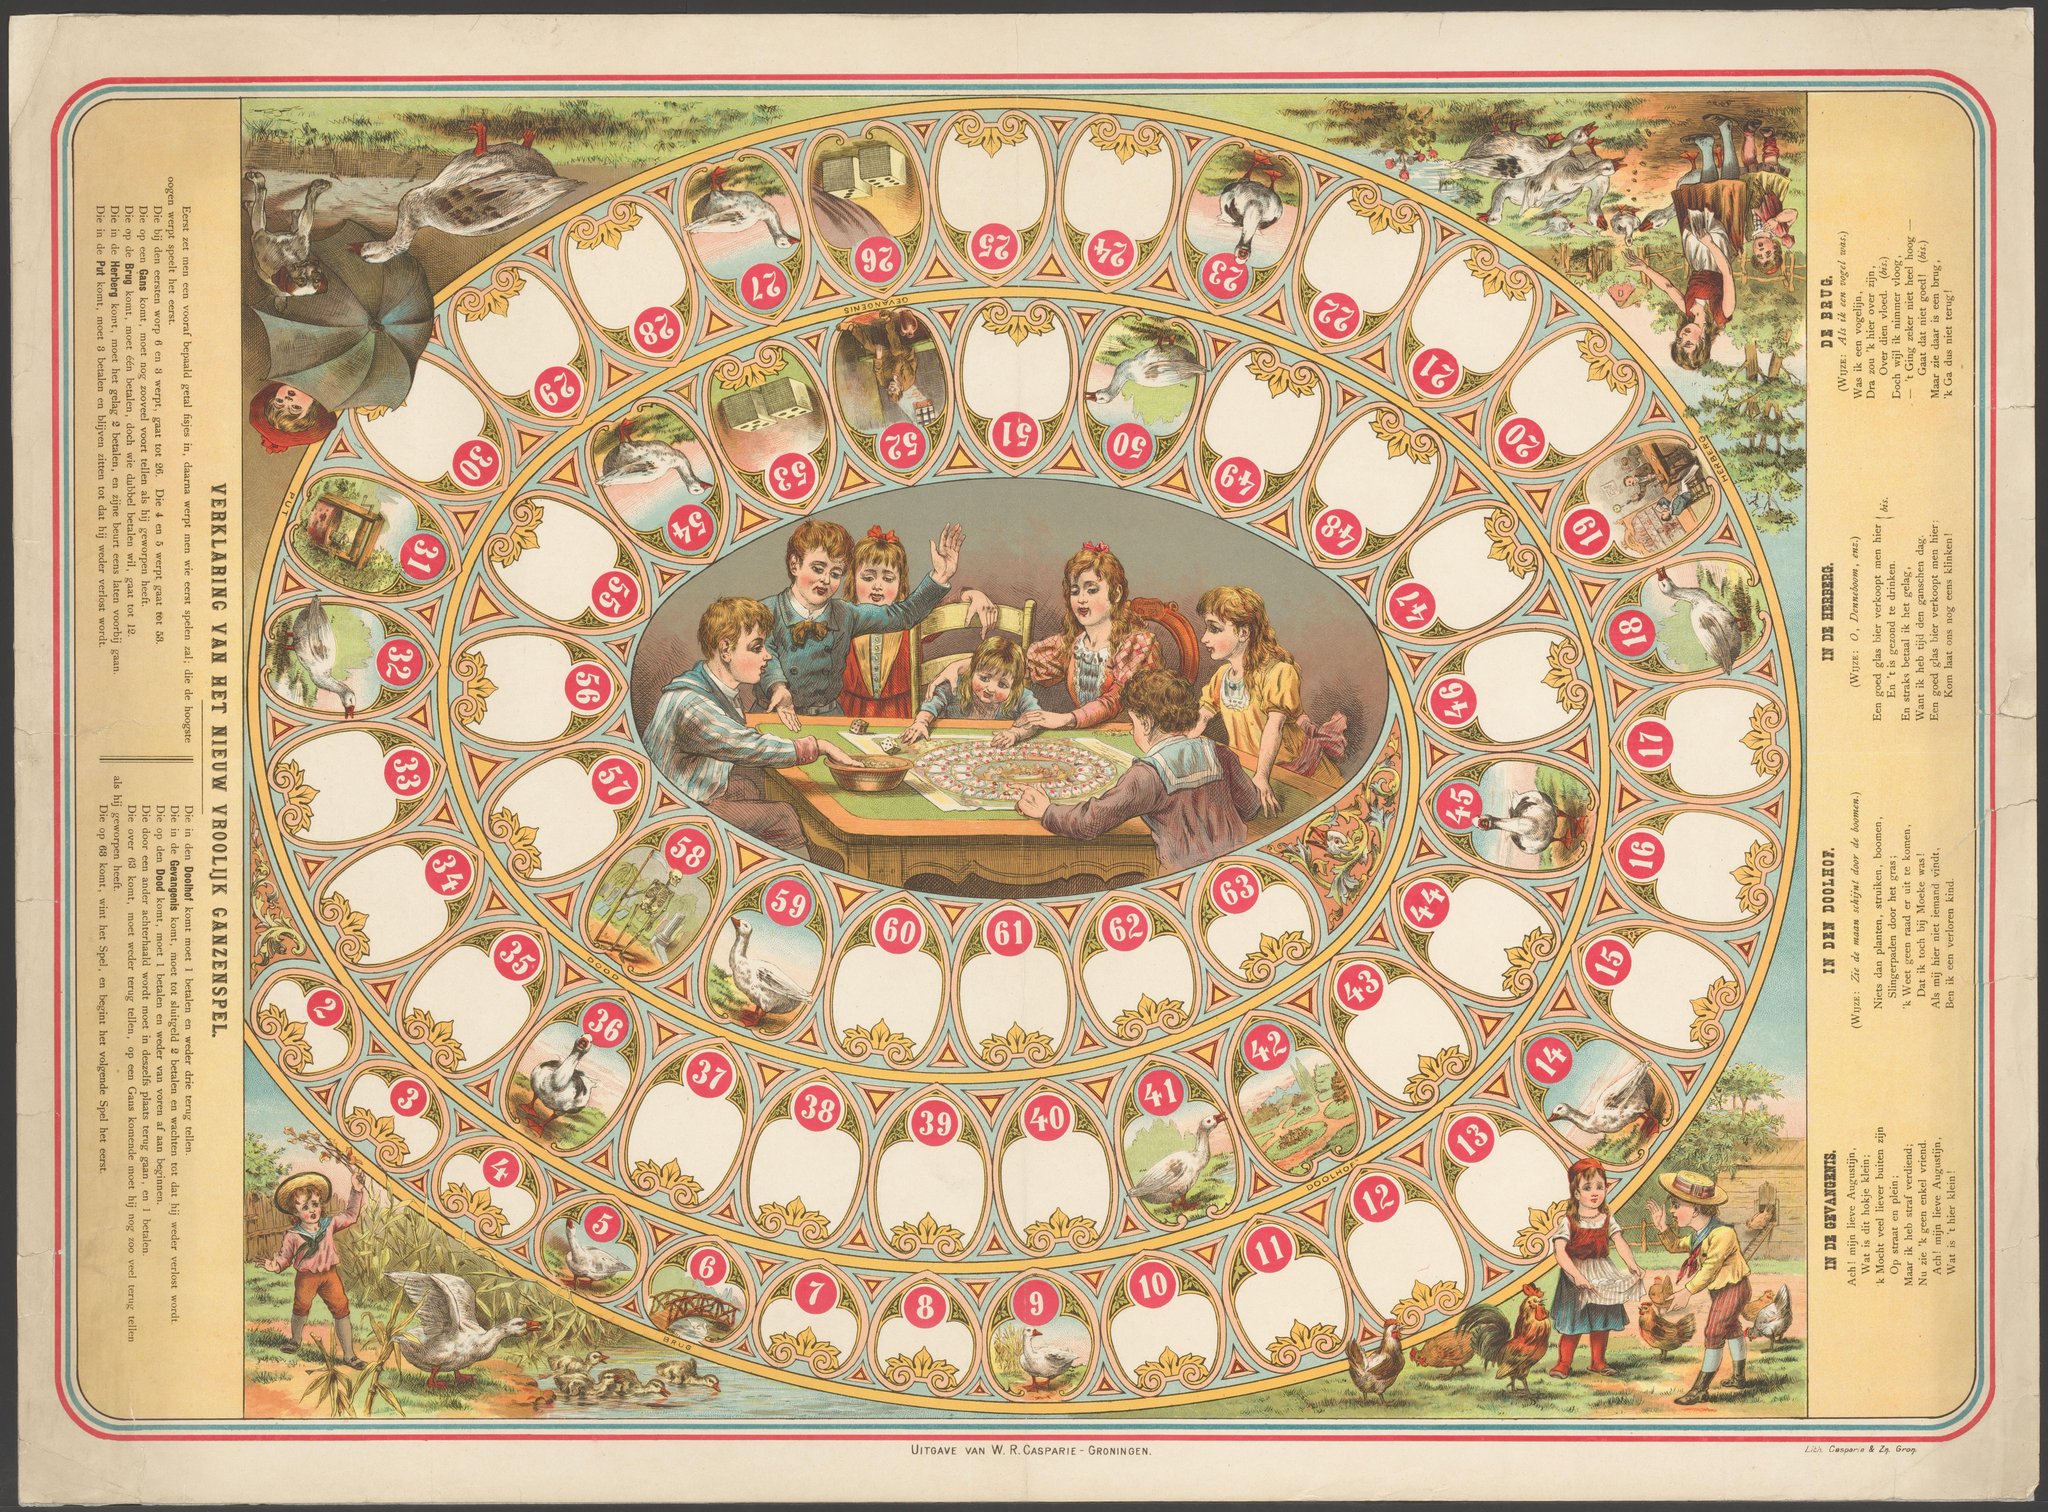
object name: print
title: Het nieuw vroolijk ganzenspel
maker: wensel robertus casparie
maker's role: bookseller, publisher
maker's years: 1828-1910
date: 1852-1910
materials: paper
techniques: lithograph, letterpress printing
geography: groningen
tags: goose-game, board-games of chance, board-games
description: Ganzenbordspel met vakken in een spiraal, genummerd van 2 tot en met 63. Op het middenveld een voorstelling van een groep kinderen aan tafel die een spellen ganzenbord speelt. In de hoeken kinderen en ganzen. Links en rechts van het bordspel de spelregels. Onderwerpsrubrieken binnen de Atlas Zeden en Gewoonten: Zeden en gewoonten in engeren zin, Spel en vermaak, Gezelschapsspel II, Ganzenbord en dergelijke.